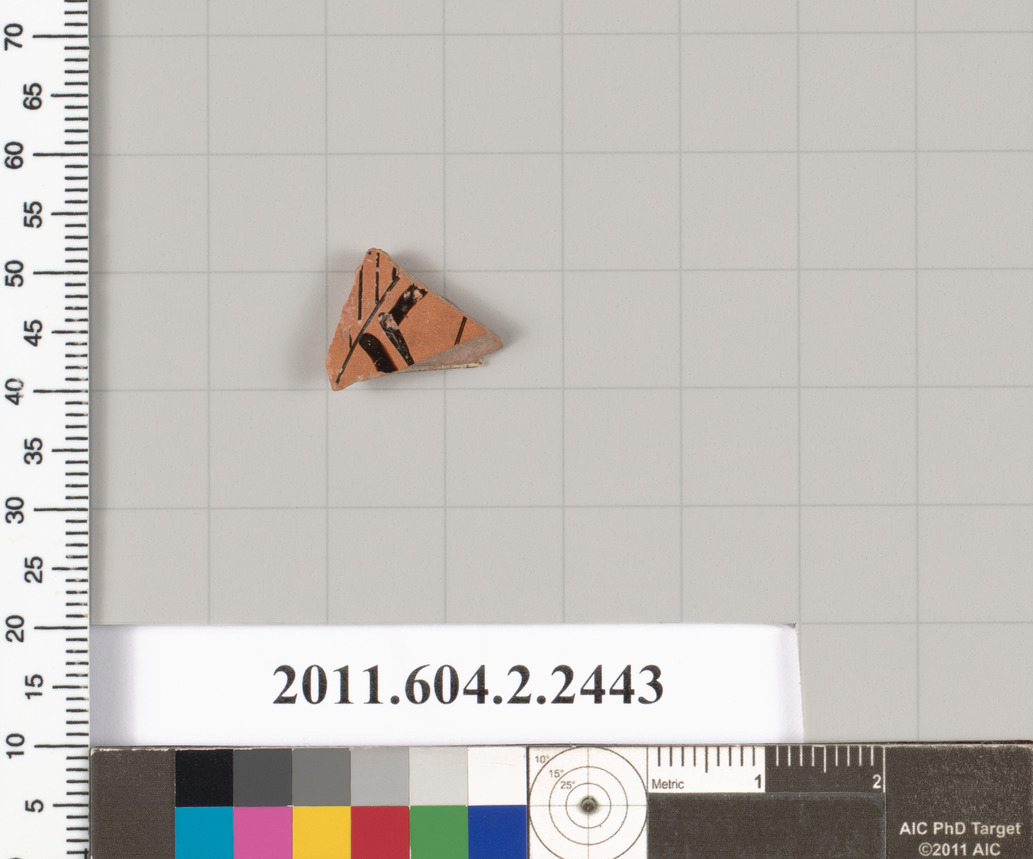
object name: pot fragment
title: Terracotta fragment of a pot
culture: greek, attic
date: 475-451 BCE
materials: terracotta